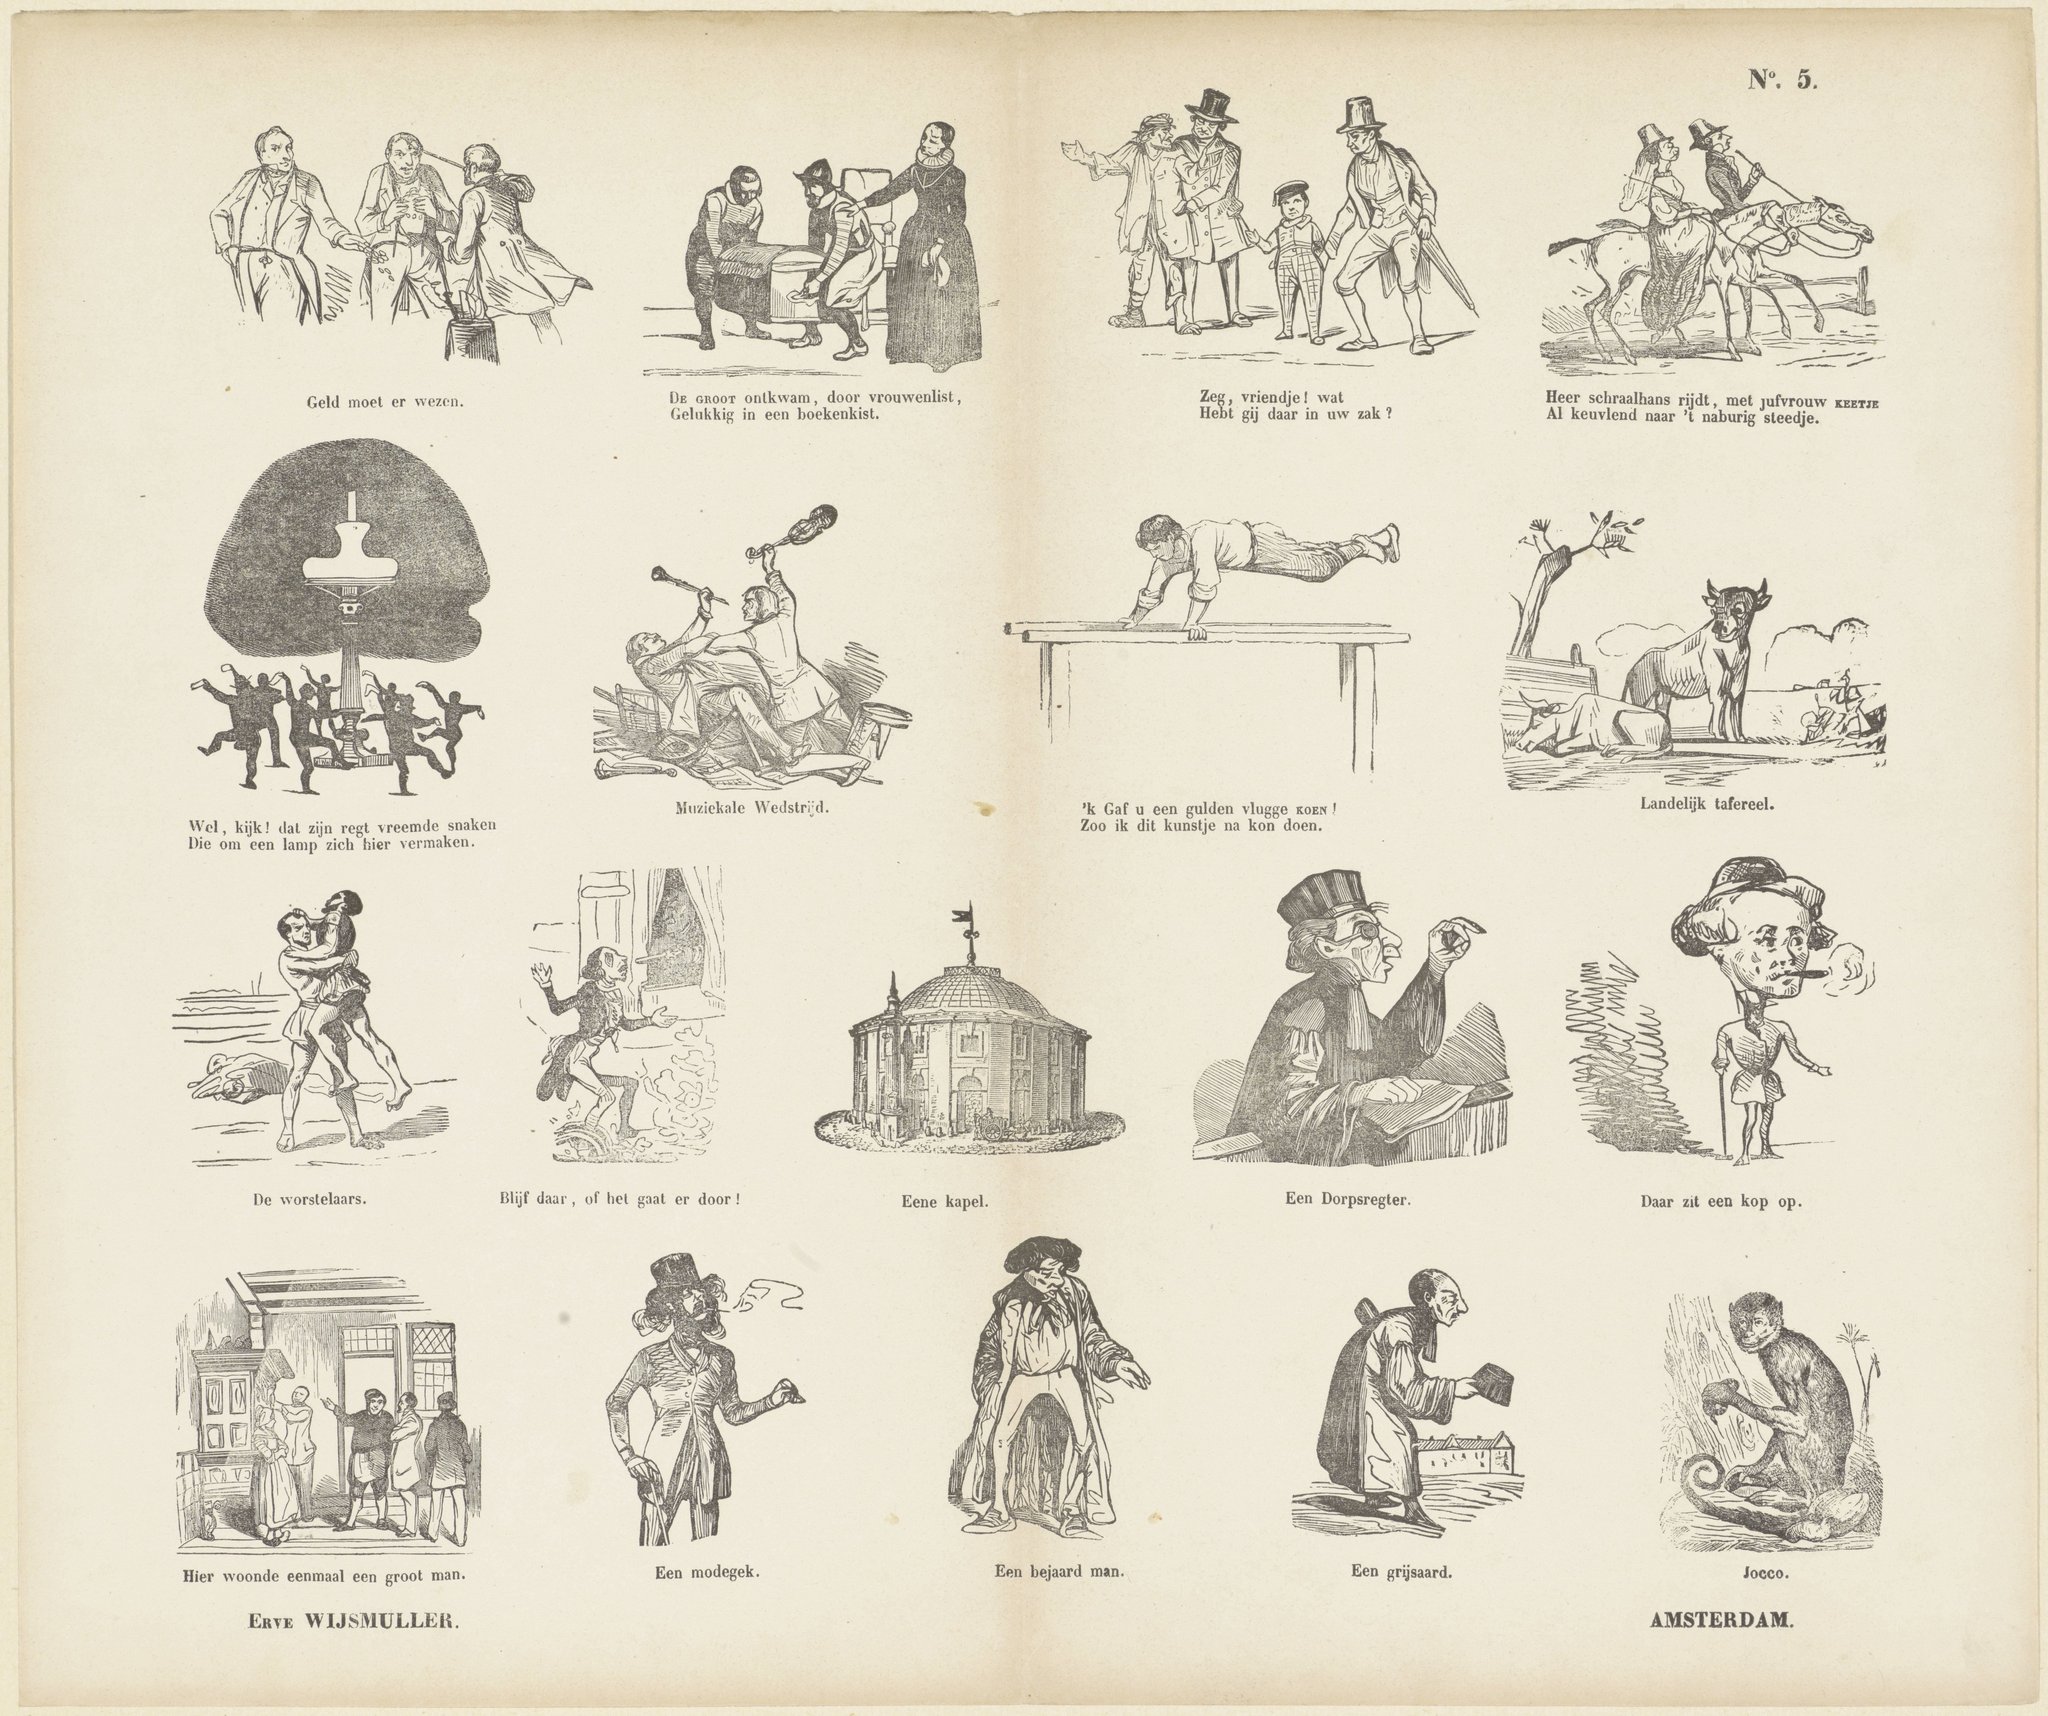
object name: print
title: Verschillende voorstellingen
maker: Anonymous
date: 1828-1913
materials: paper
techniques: letterpress printing, line block, engraving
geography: amsterdam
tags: dancing, characters (human types), athletics, gymnastics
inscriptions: collector's mark: Lugt 2760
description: Blad met 18 voorstellingen van verschillende aard, waaronder de vlucht van Hugo de Groot in de boekenkist, een man die gefouilleerd wordt en een groep mensen dansen rond een olielamp. Onder elke afbeelding een onderschrift. Onder de eerste afbeelding het onderschrift: Geld moet er wezen. Genummerd rechtsboven: No. 5.